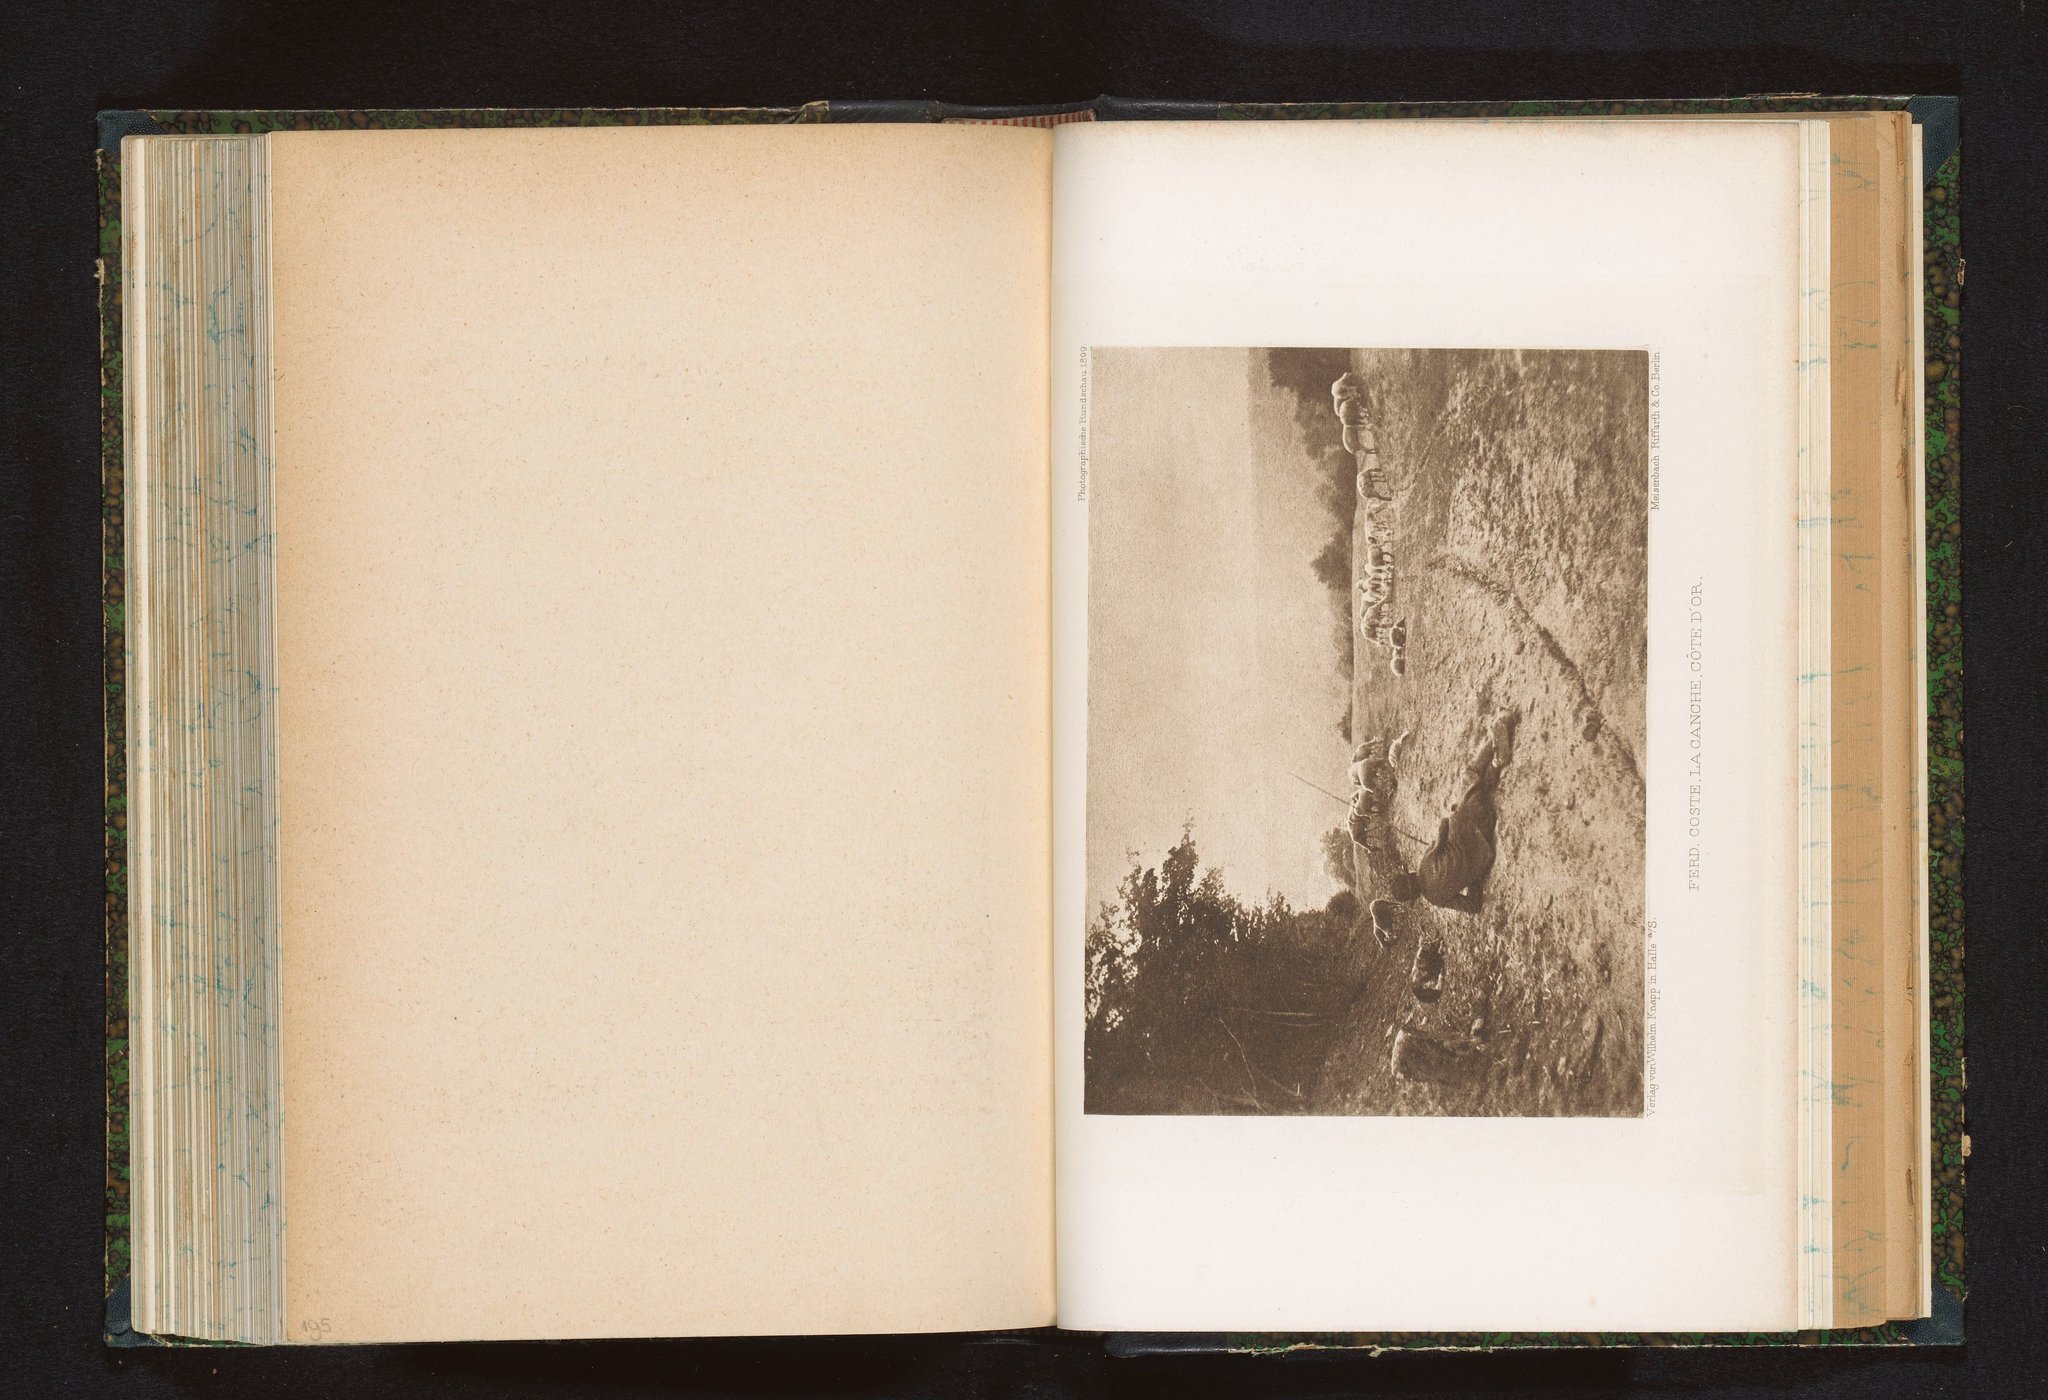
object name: photomechanical print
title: Herder en kudde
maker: jean-ferdinand coste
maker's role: fotograaf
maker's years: 1861-1932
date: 1894-1899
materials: paper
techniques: photoaquatint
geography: gold coast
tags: herding, herdsman, herdswoman, shepherd, shepherdess, cowherd, etc.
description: Prent op tweede ongenummerde pagina na pagina 368.